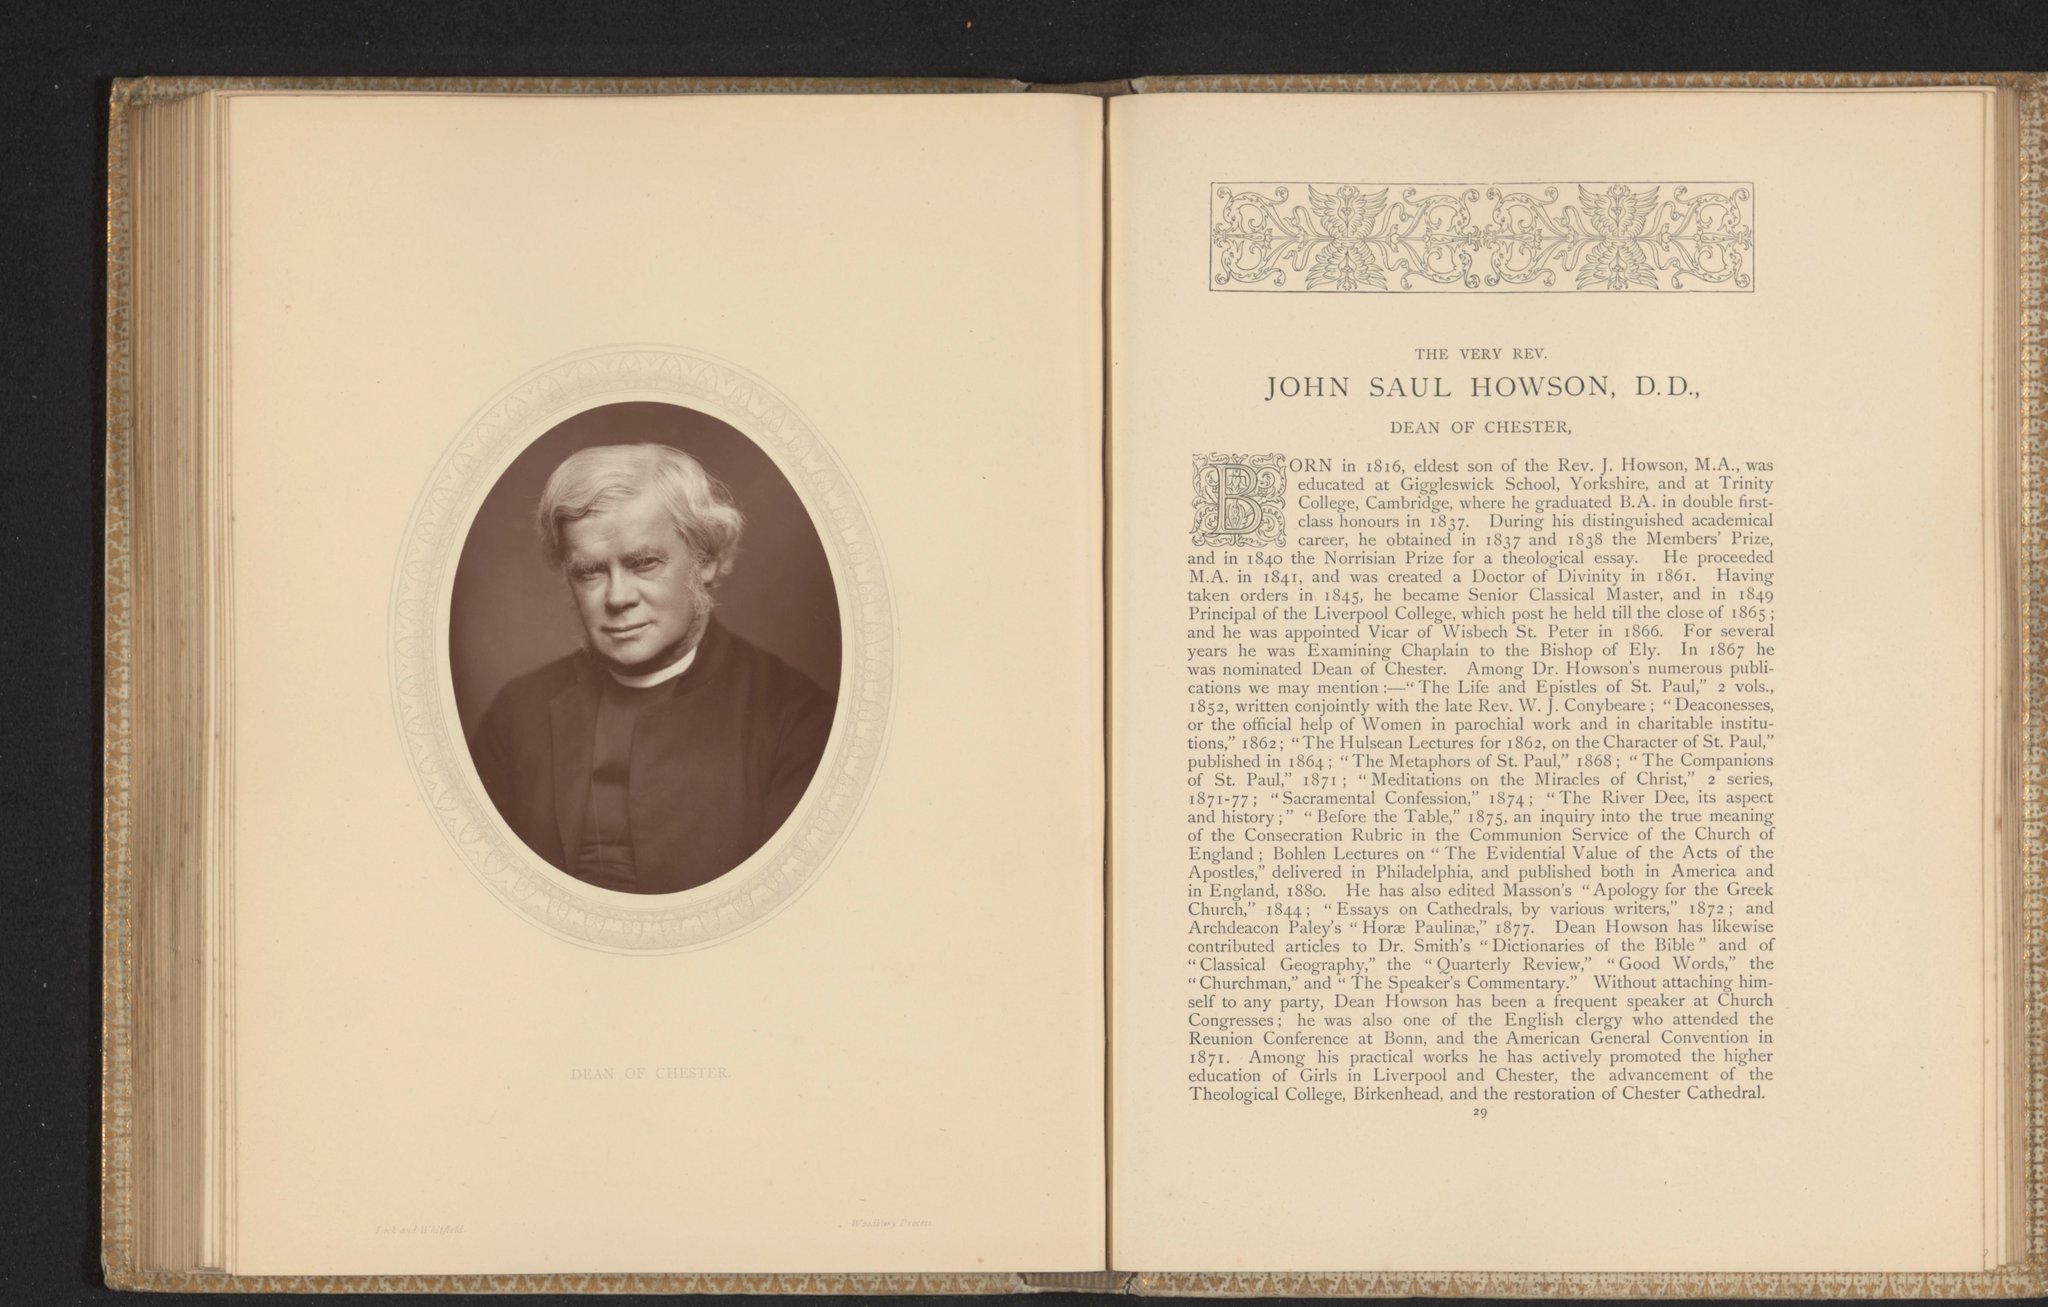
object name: photomechanical print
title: Dean of Chester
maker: Anonymous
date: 1877-1882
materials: paper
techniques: woodburytype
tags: priest, priest (roman catholic), historical persons (portraits and scenes from the life) (+ (full) bust portrait)